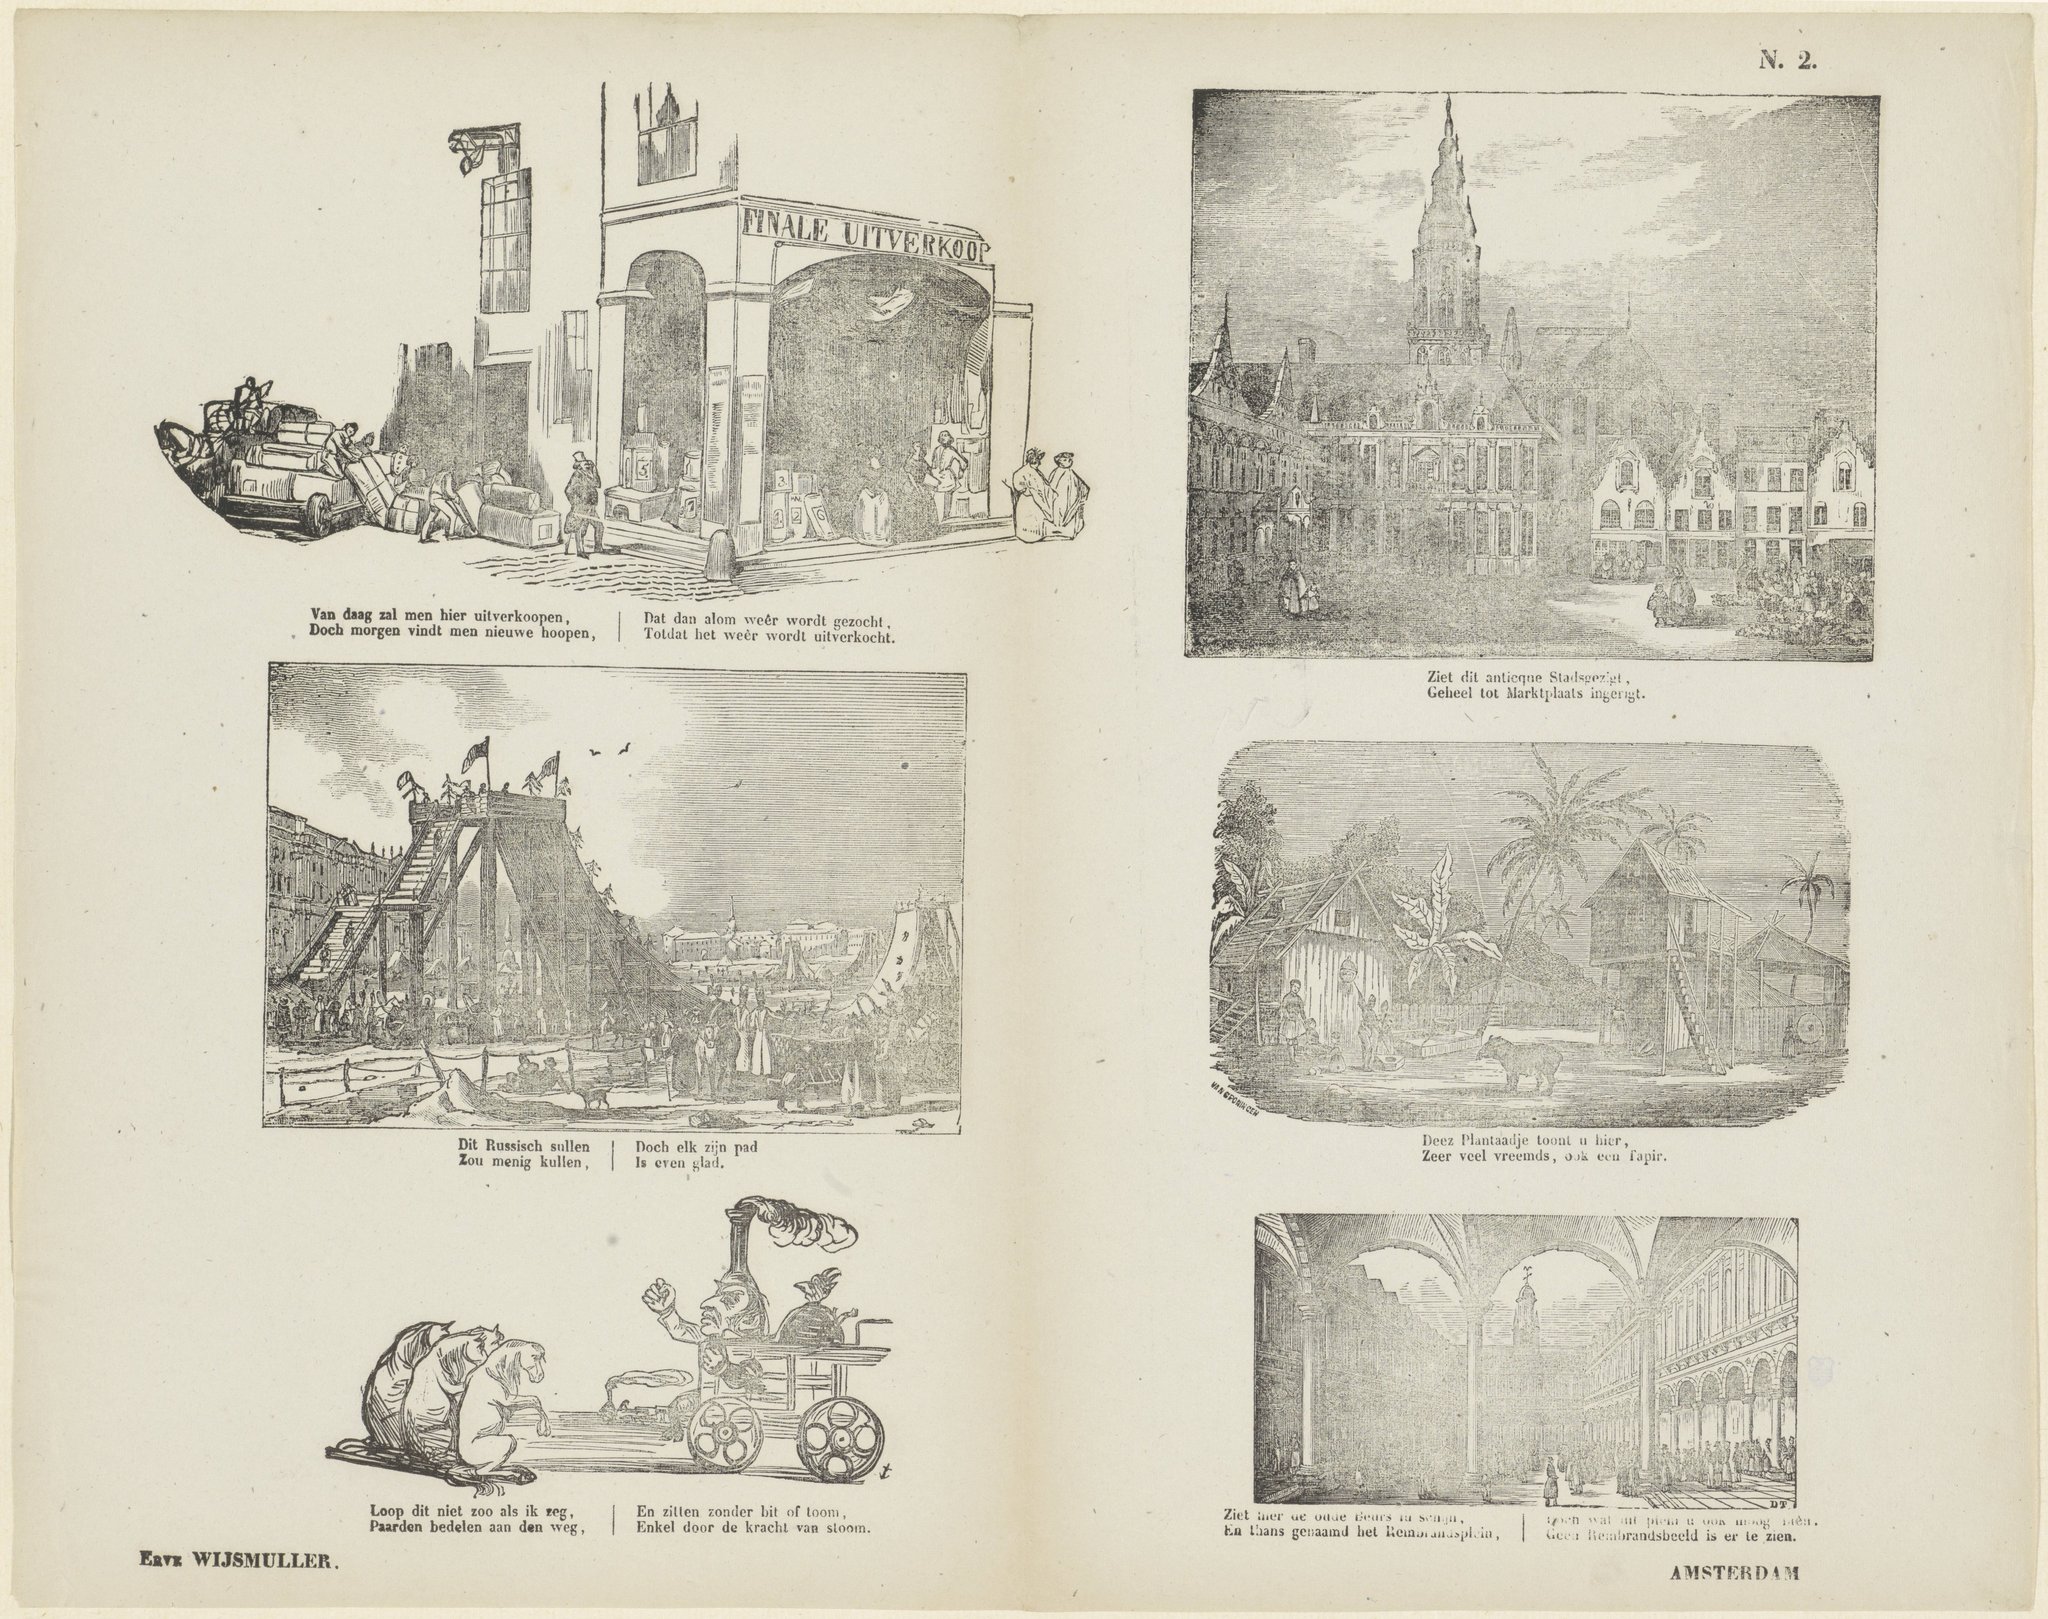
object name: popular print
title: Verschillende voorstellingen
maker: Anonymous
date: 1828-1913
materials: paper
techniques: letterpress printing, line block, engraving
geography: netherlands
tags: shop, store, city-view, and landscape with man-made constructions, slide, chute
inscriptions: collector's mark: Lugt 2760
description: Blad met 6 voorstellingen van verschillende aard, waaronder een winkel, een marktplein en een Russische glijbaan. Onder elke afbeelding een onderschrift. Onder de eerste afbeelding het onderschrift: Van daag zal men hier uitverkoopen... Genummerd rechtsboven: N. 2.